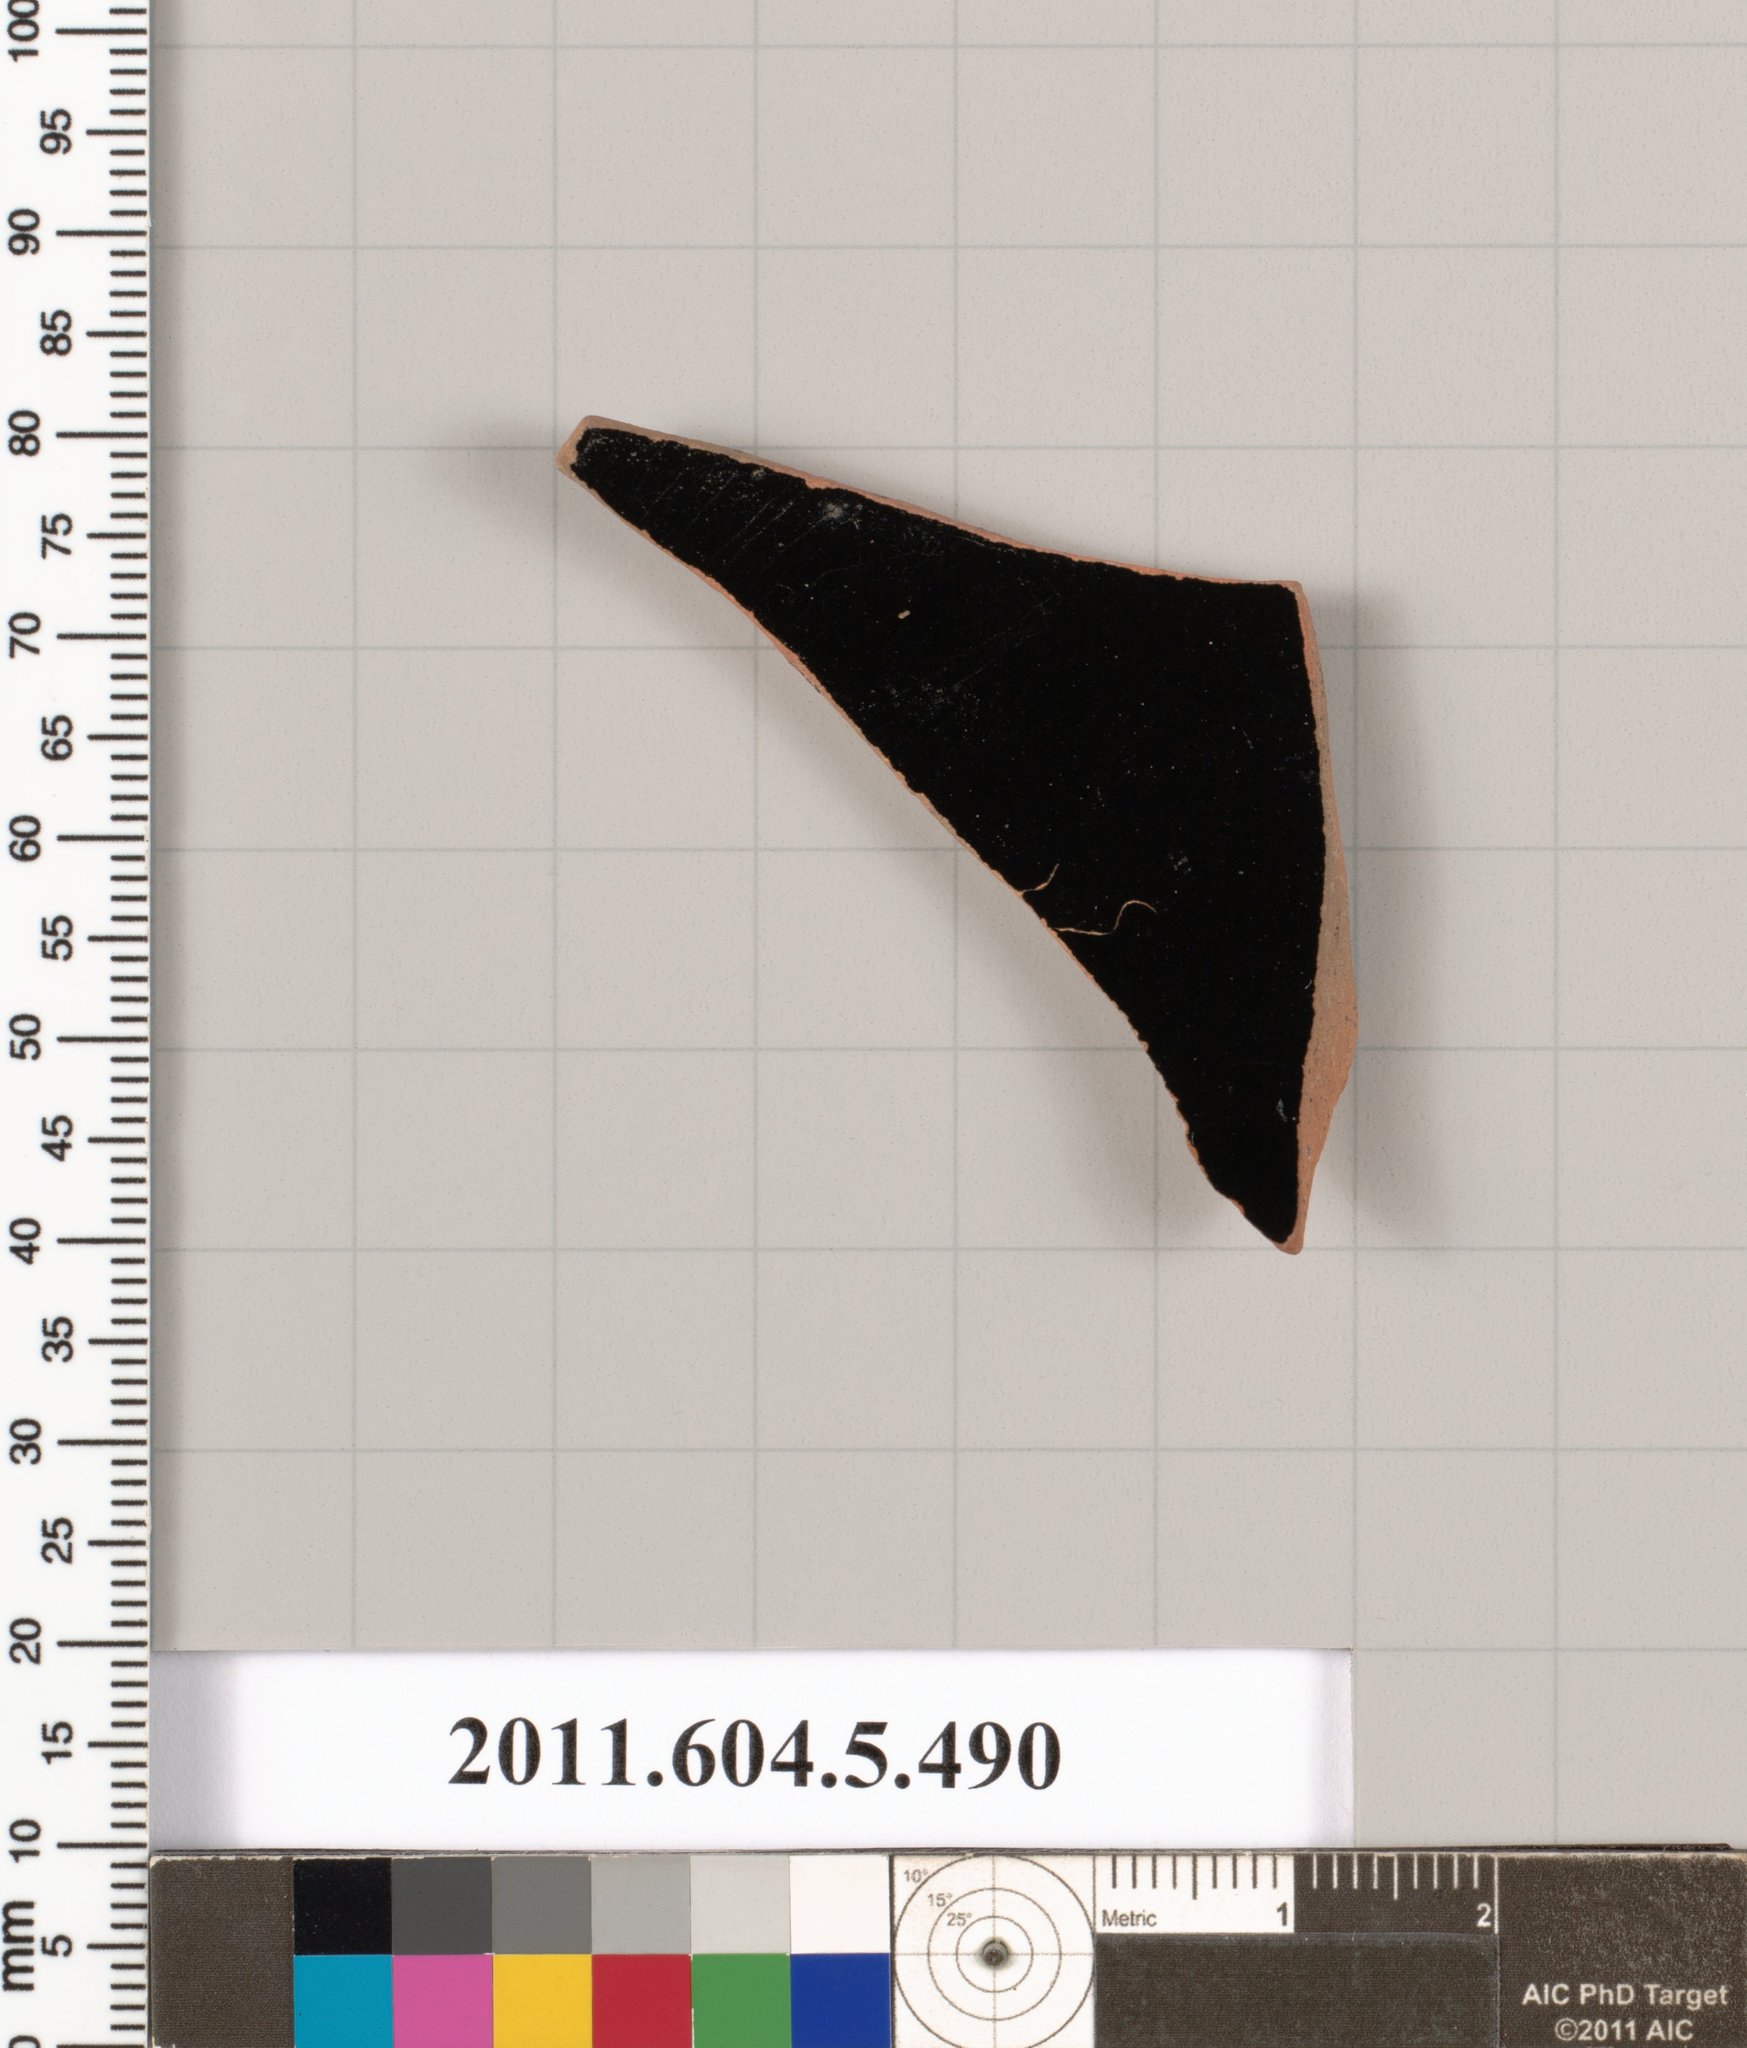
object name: kylix fragment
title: Terracotta fragment of a kylix (drinking cup)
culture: greek, attic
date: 600-401 BCE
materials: terracotta